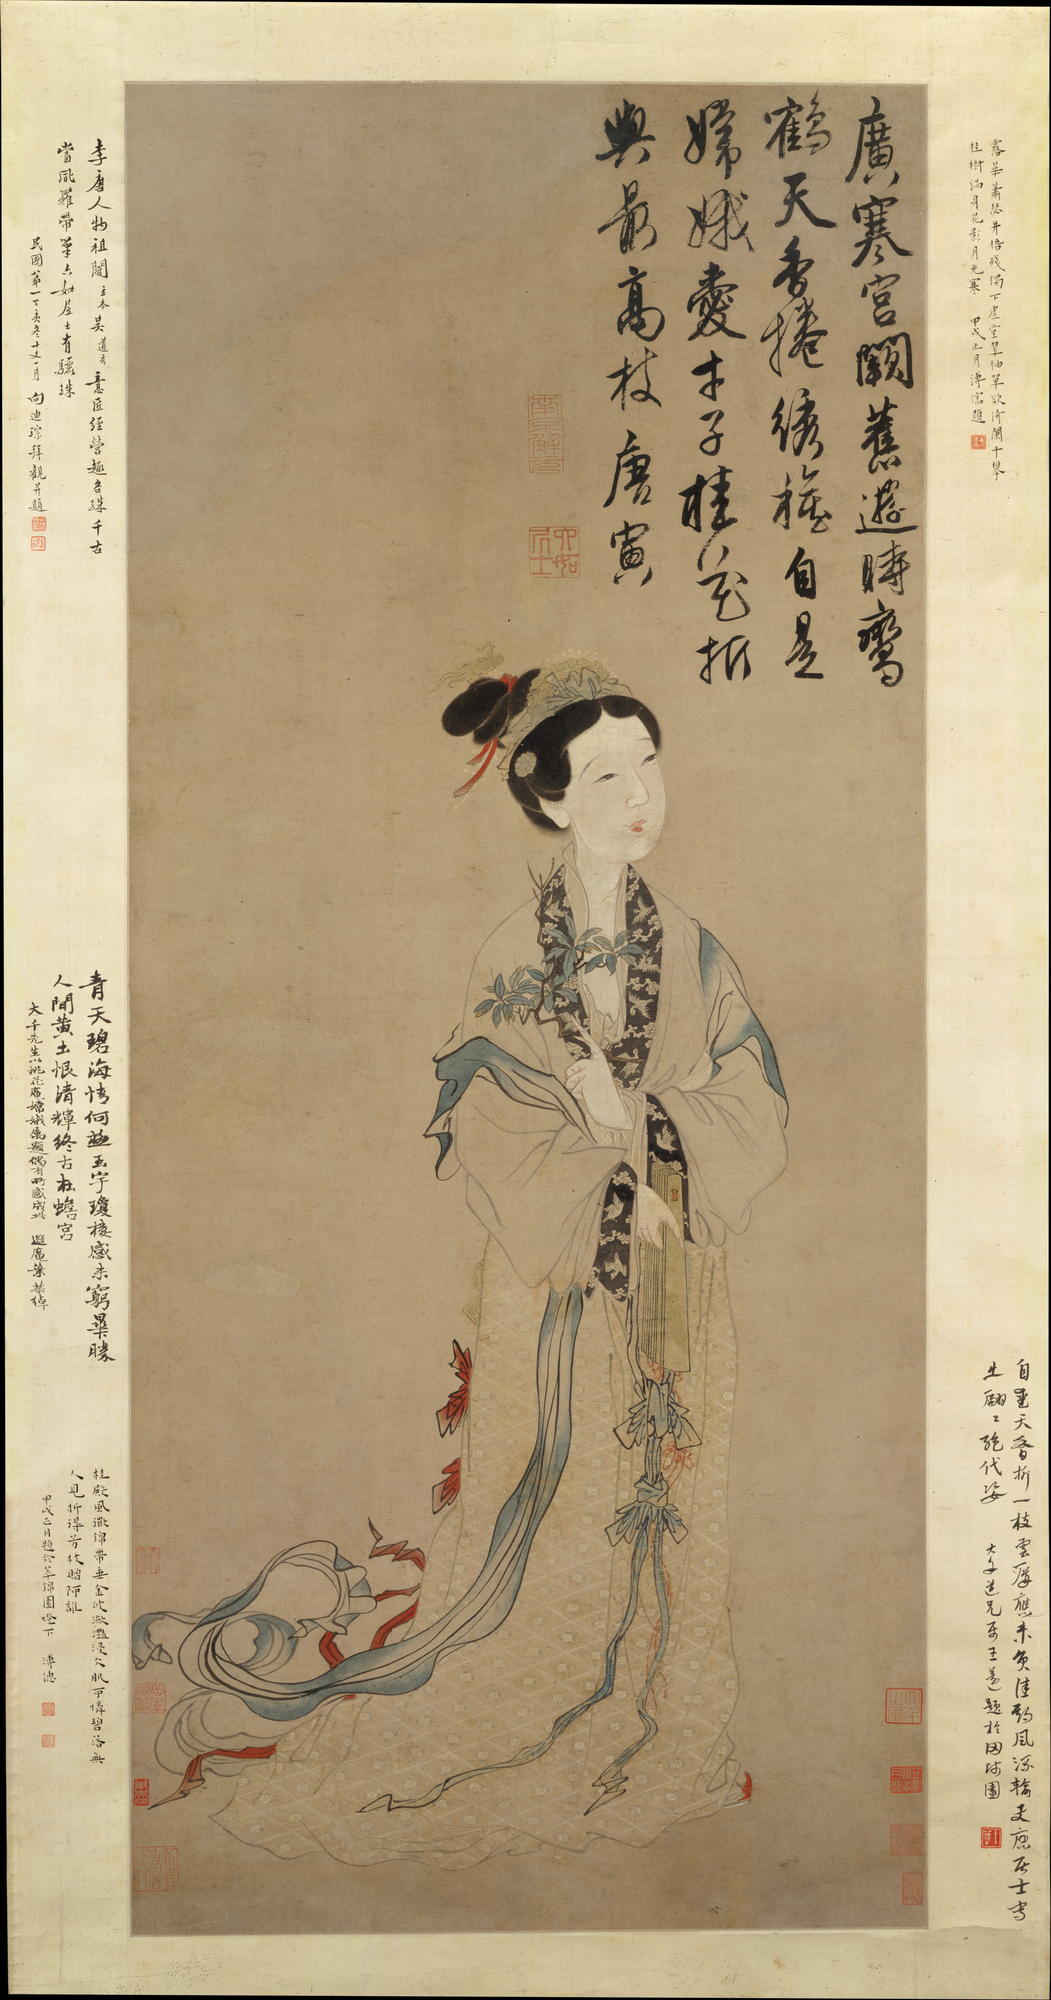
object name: hanging scroll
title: The Moon Goddess Chang E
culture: chinese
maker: unidentified artist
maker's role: artist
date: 1368-1644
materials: ink, paper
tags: women,goddess